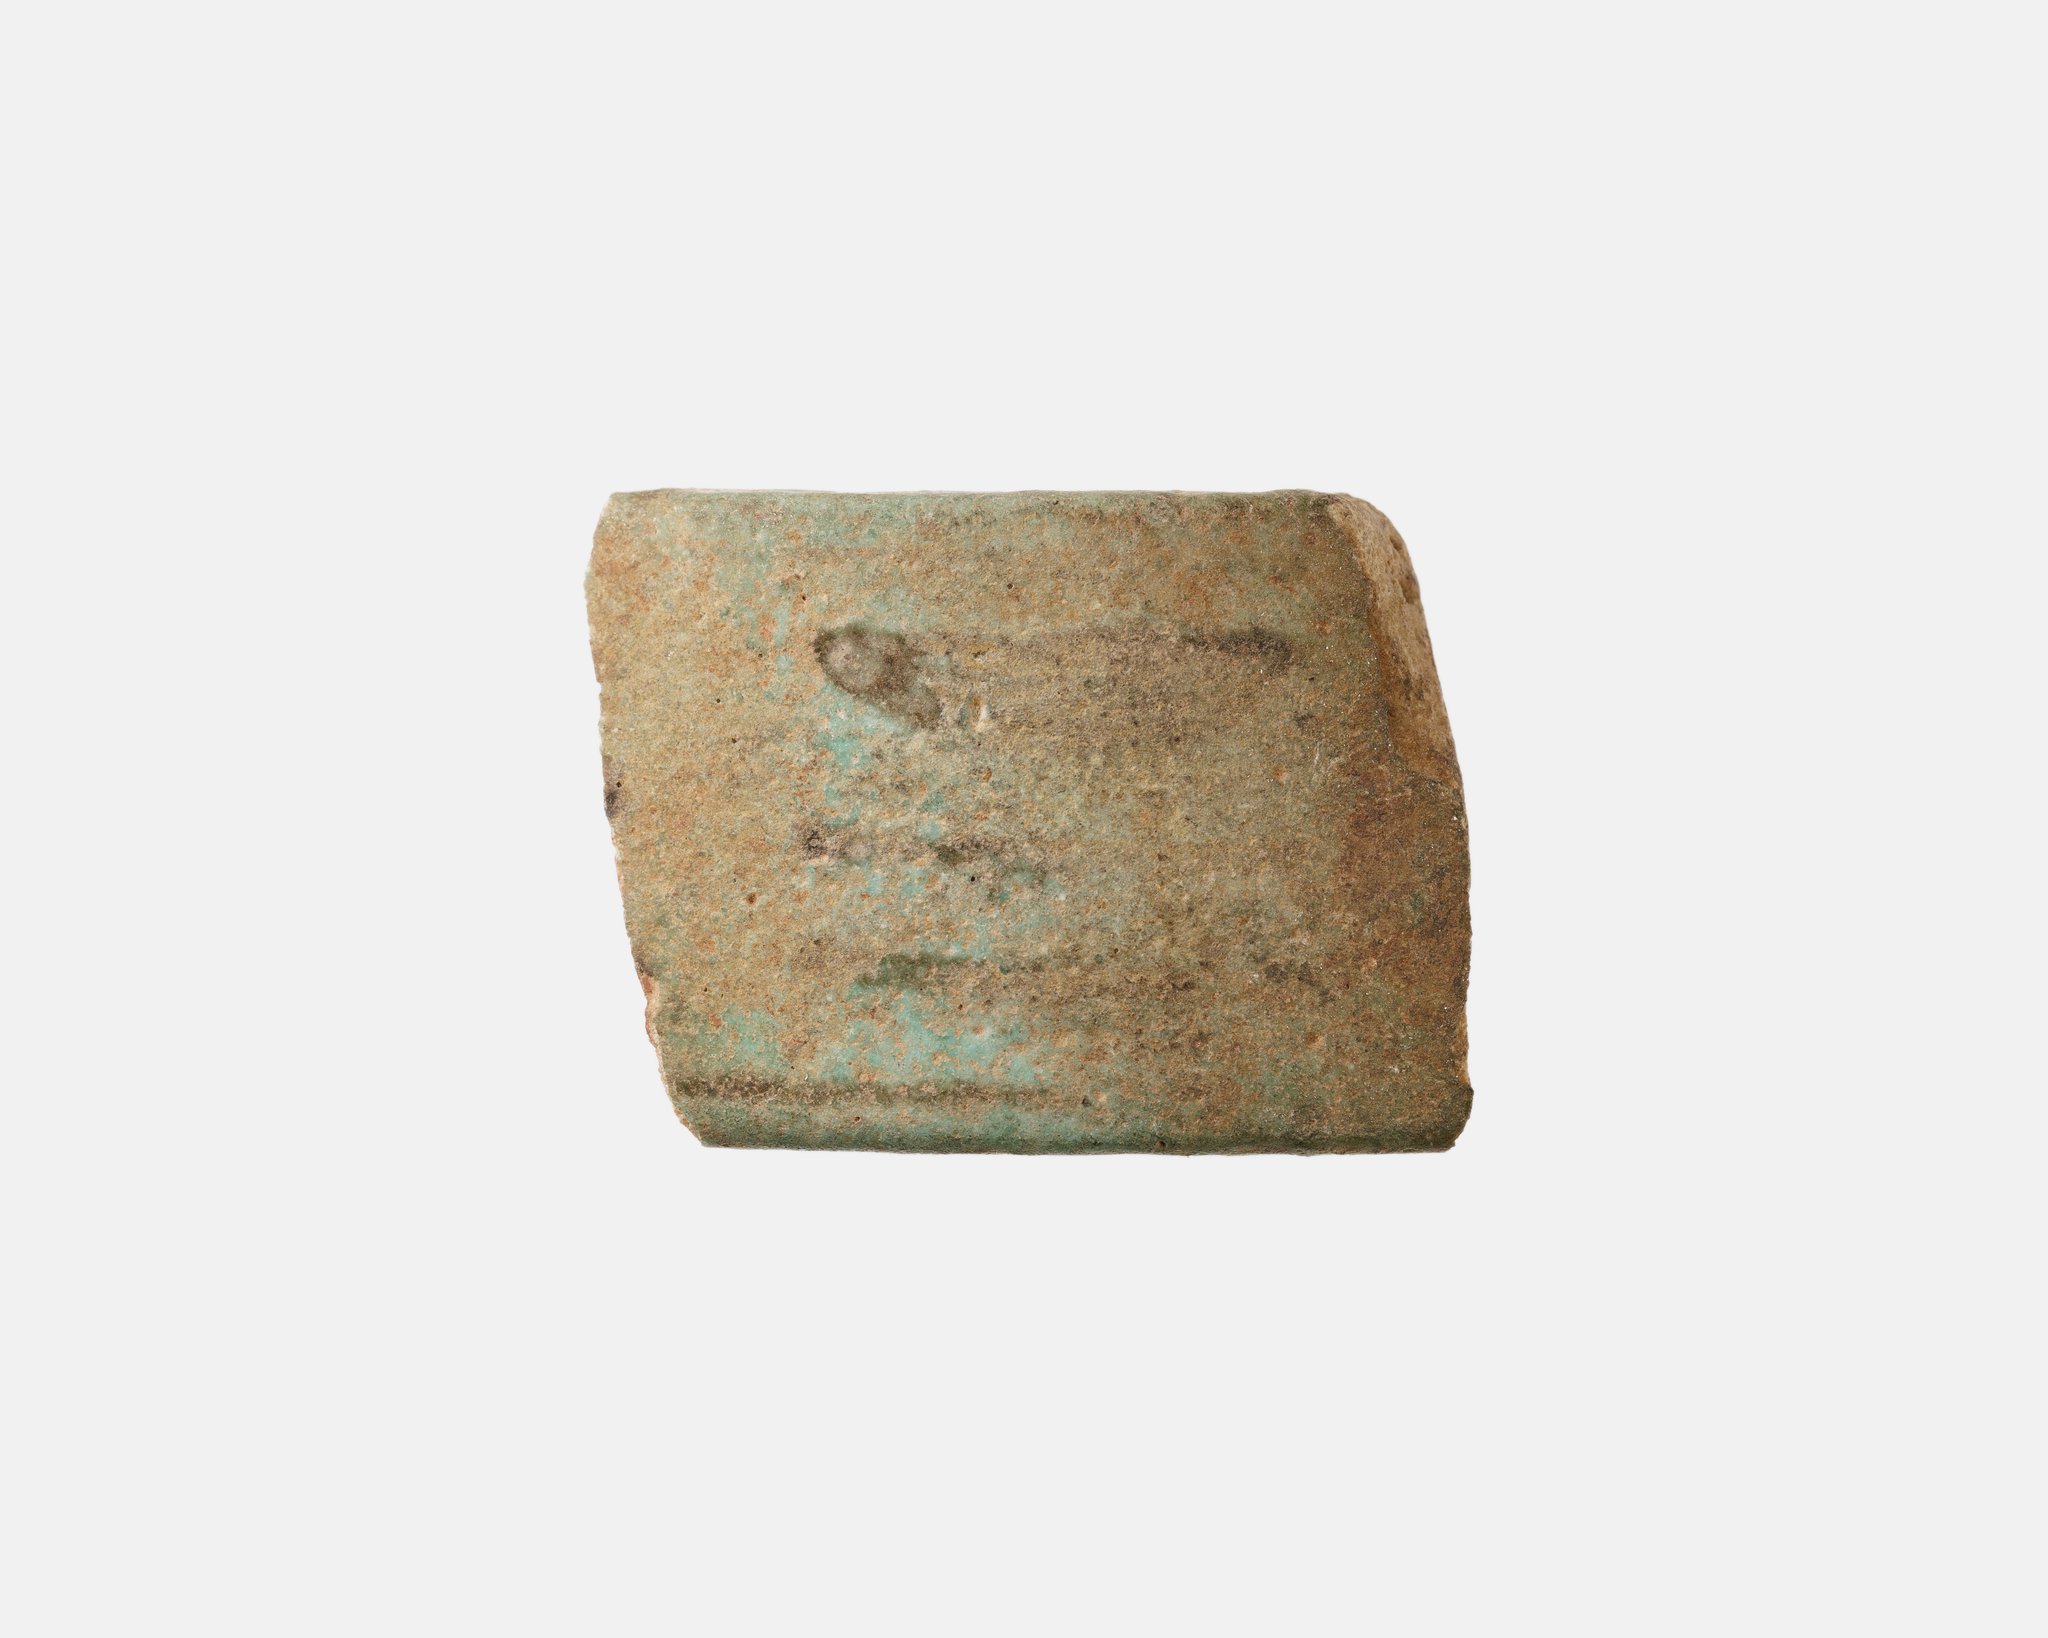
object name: votive bracelet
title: Fragment of a votive bracelet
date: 1295-1070 BCE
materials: faience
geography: egypt